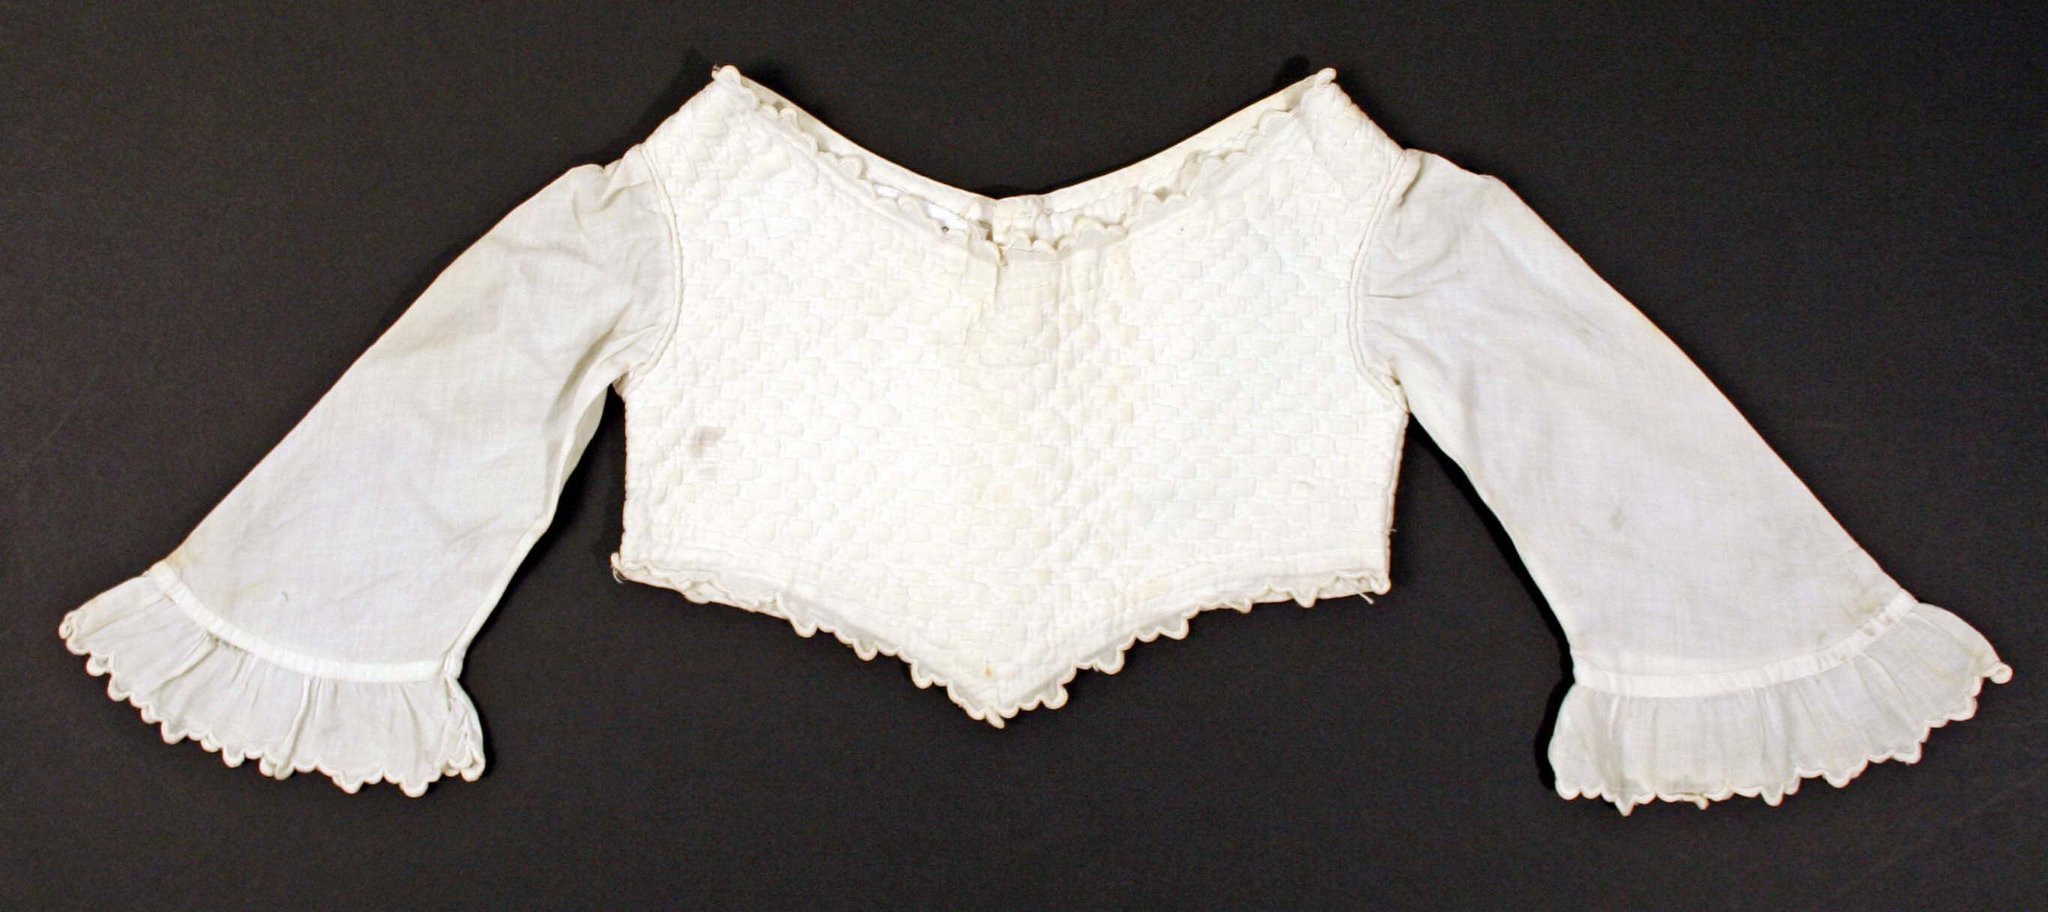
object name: bodice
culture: german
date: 1840-1849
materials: cotton